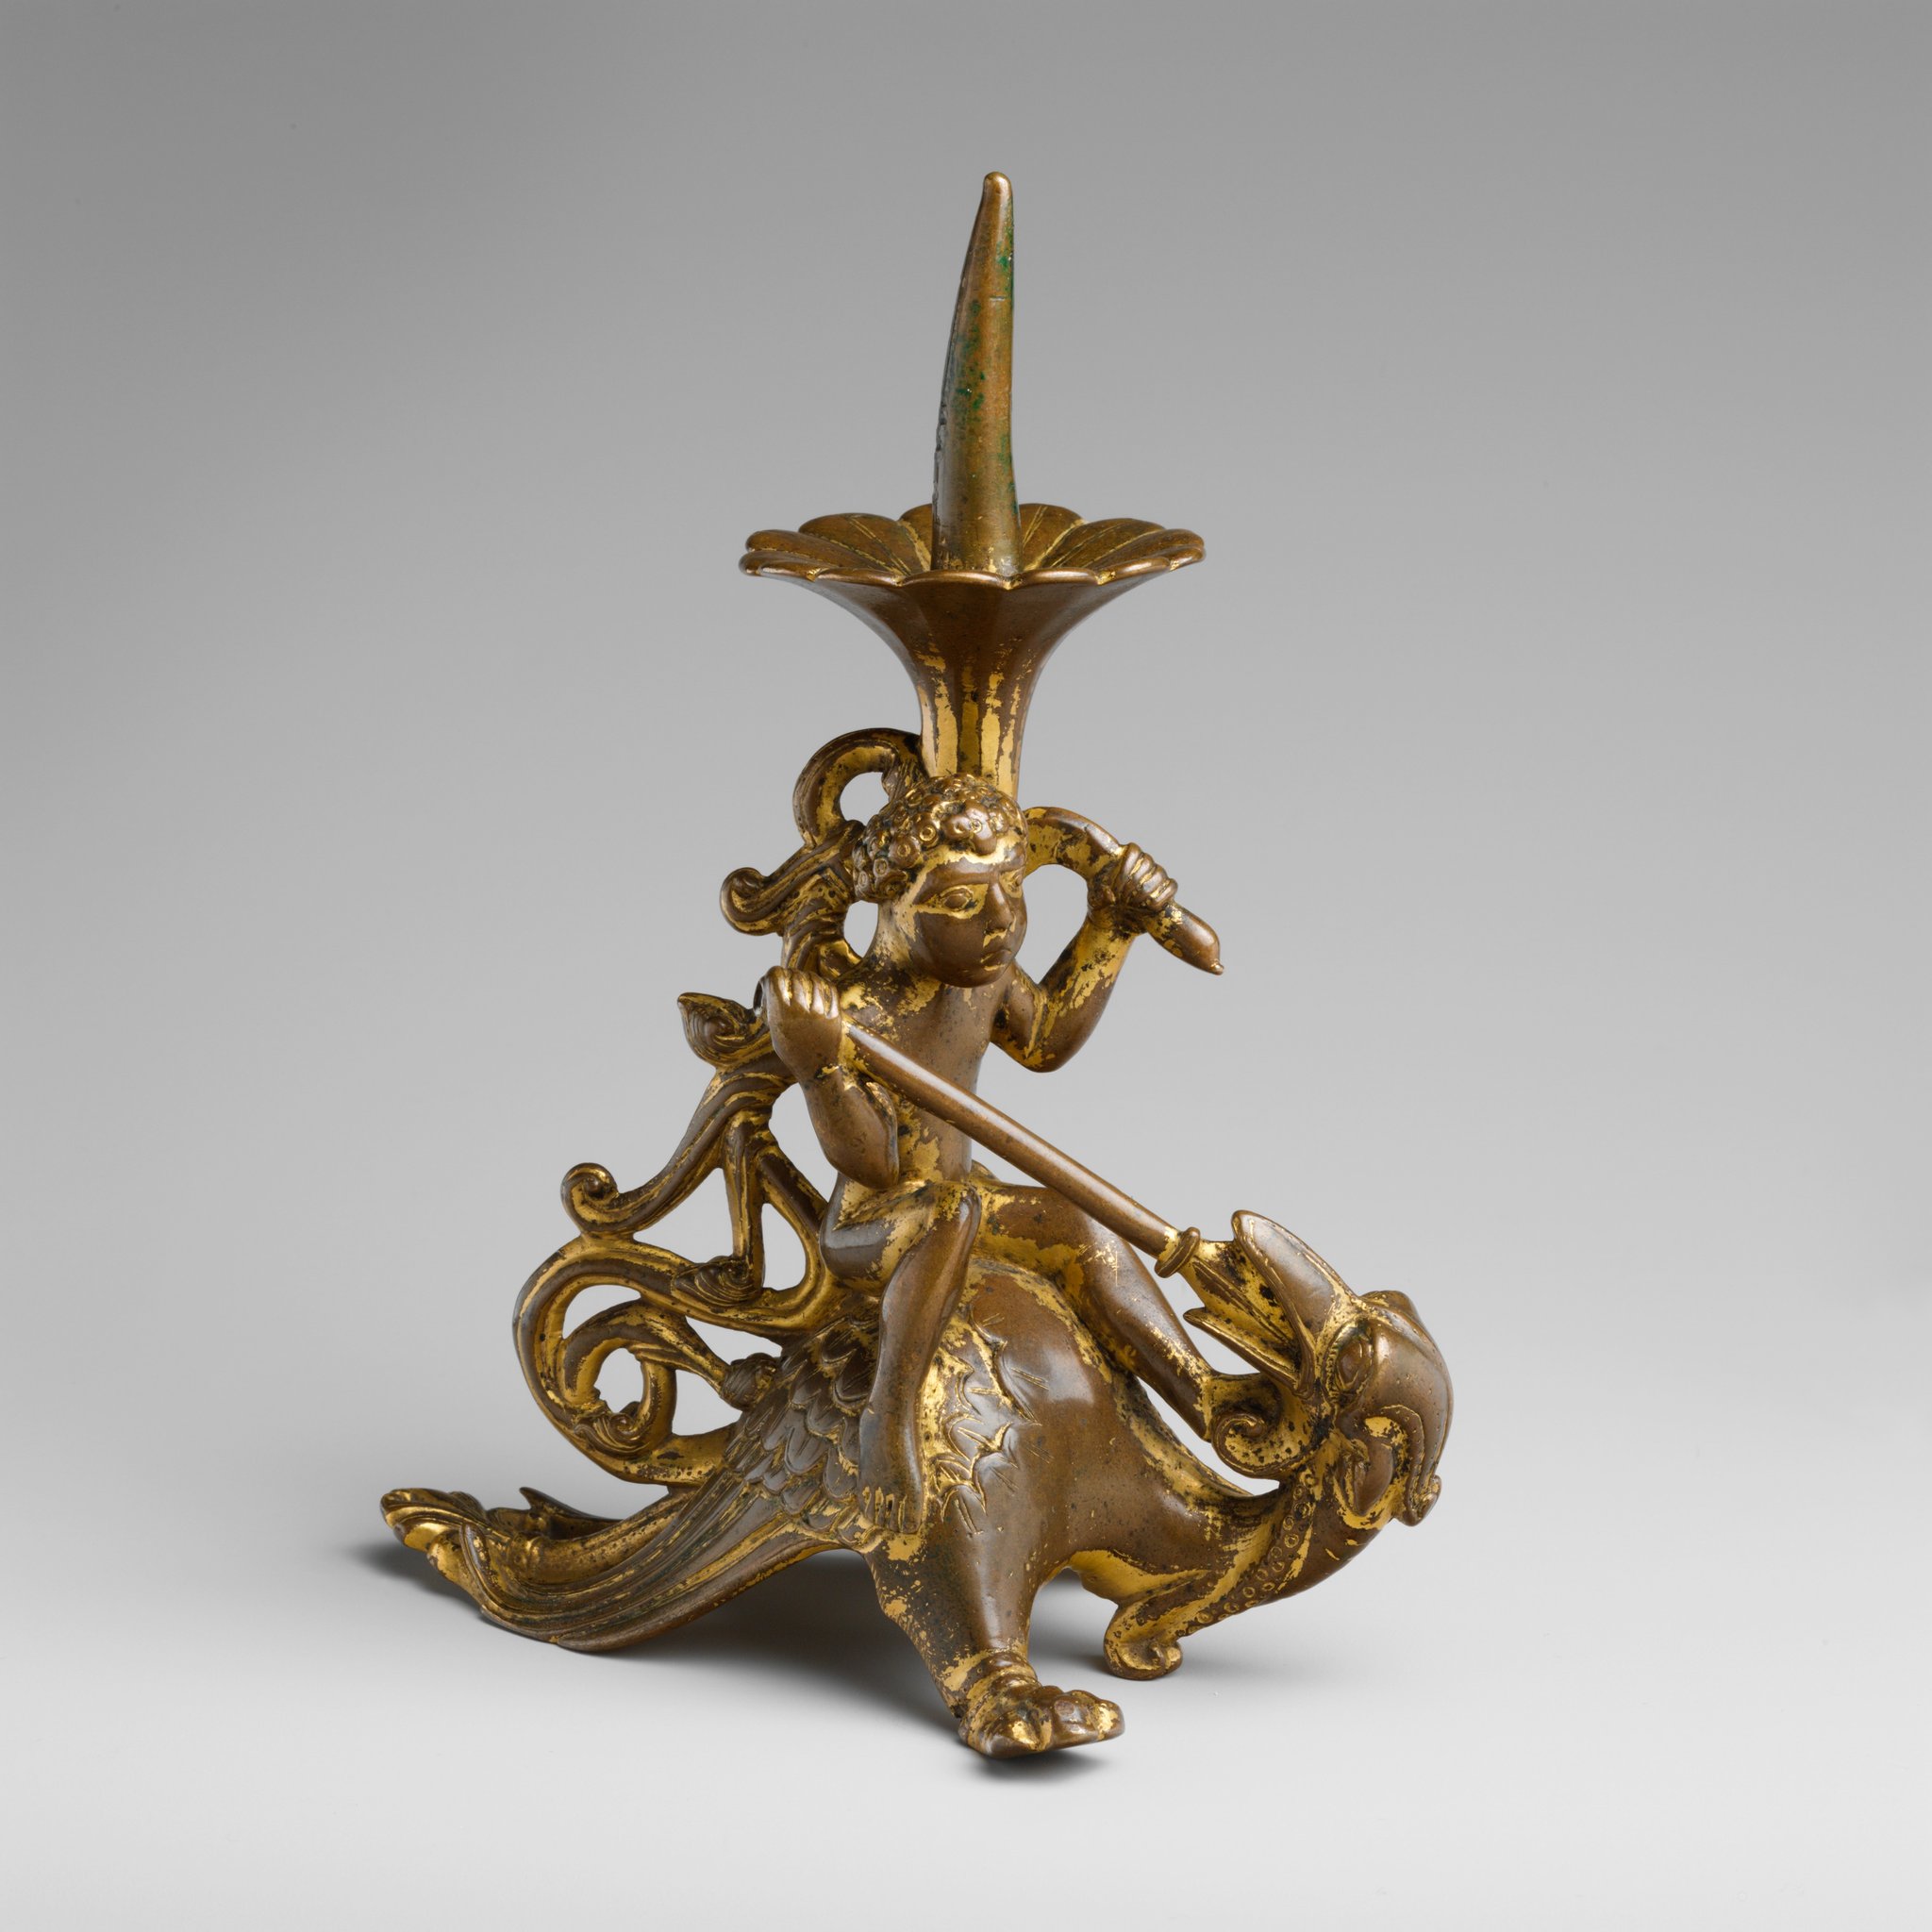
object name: candlestick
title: Pricket Candlestick with a Naked Youth Fighting a Dragon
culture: south netherlandish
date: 1140-1160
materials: alloy, gilt copper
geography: netherlands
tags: weapons,male nudes,dragons